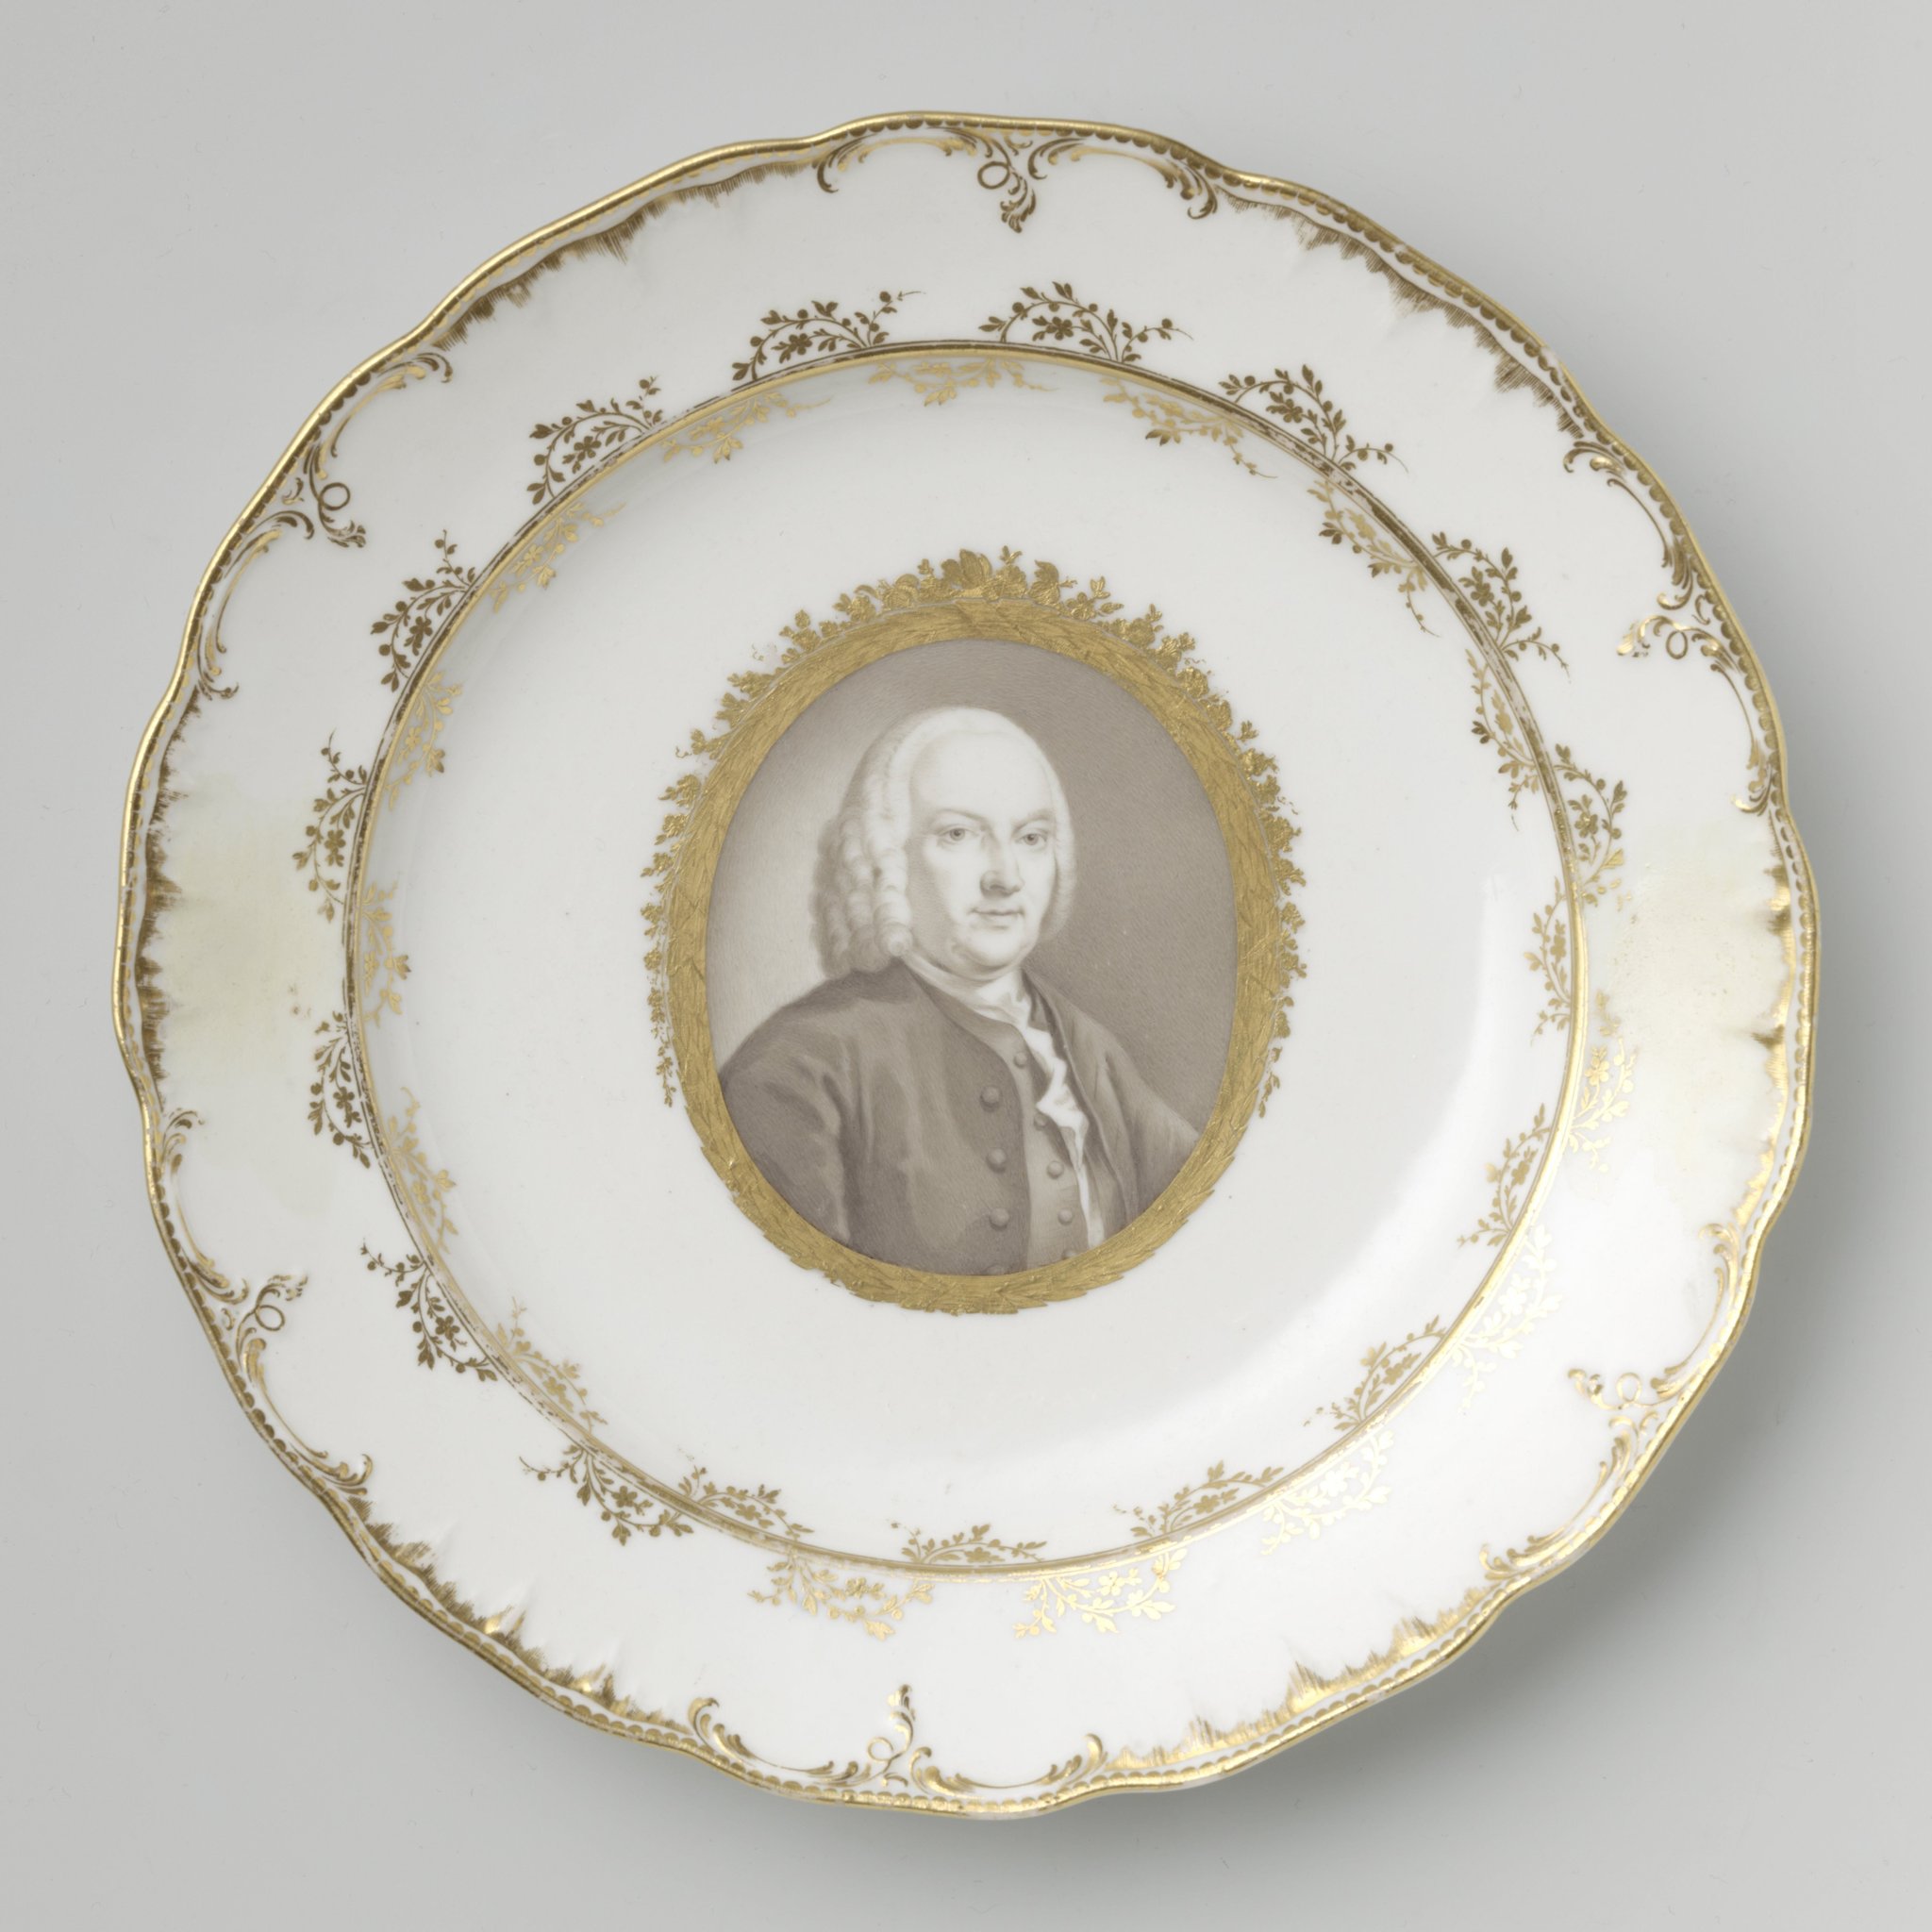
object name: plate dish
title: Bord beschilderd met het portret van Mr Gerard Aarnout Hasselaar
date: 1778-1782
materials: porcelain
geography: loosdrecht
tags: mayor, gerard aarnout hasselaer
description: Plate with a portrait of Gerard Aarnout Hasselaer (1698 - 1766). Porcelain, Loosdrecht, c. 1778-1782. Factory of Joannes de Mol. H.C. Hooft Hasselaer bequest, 1963.